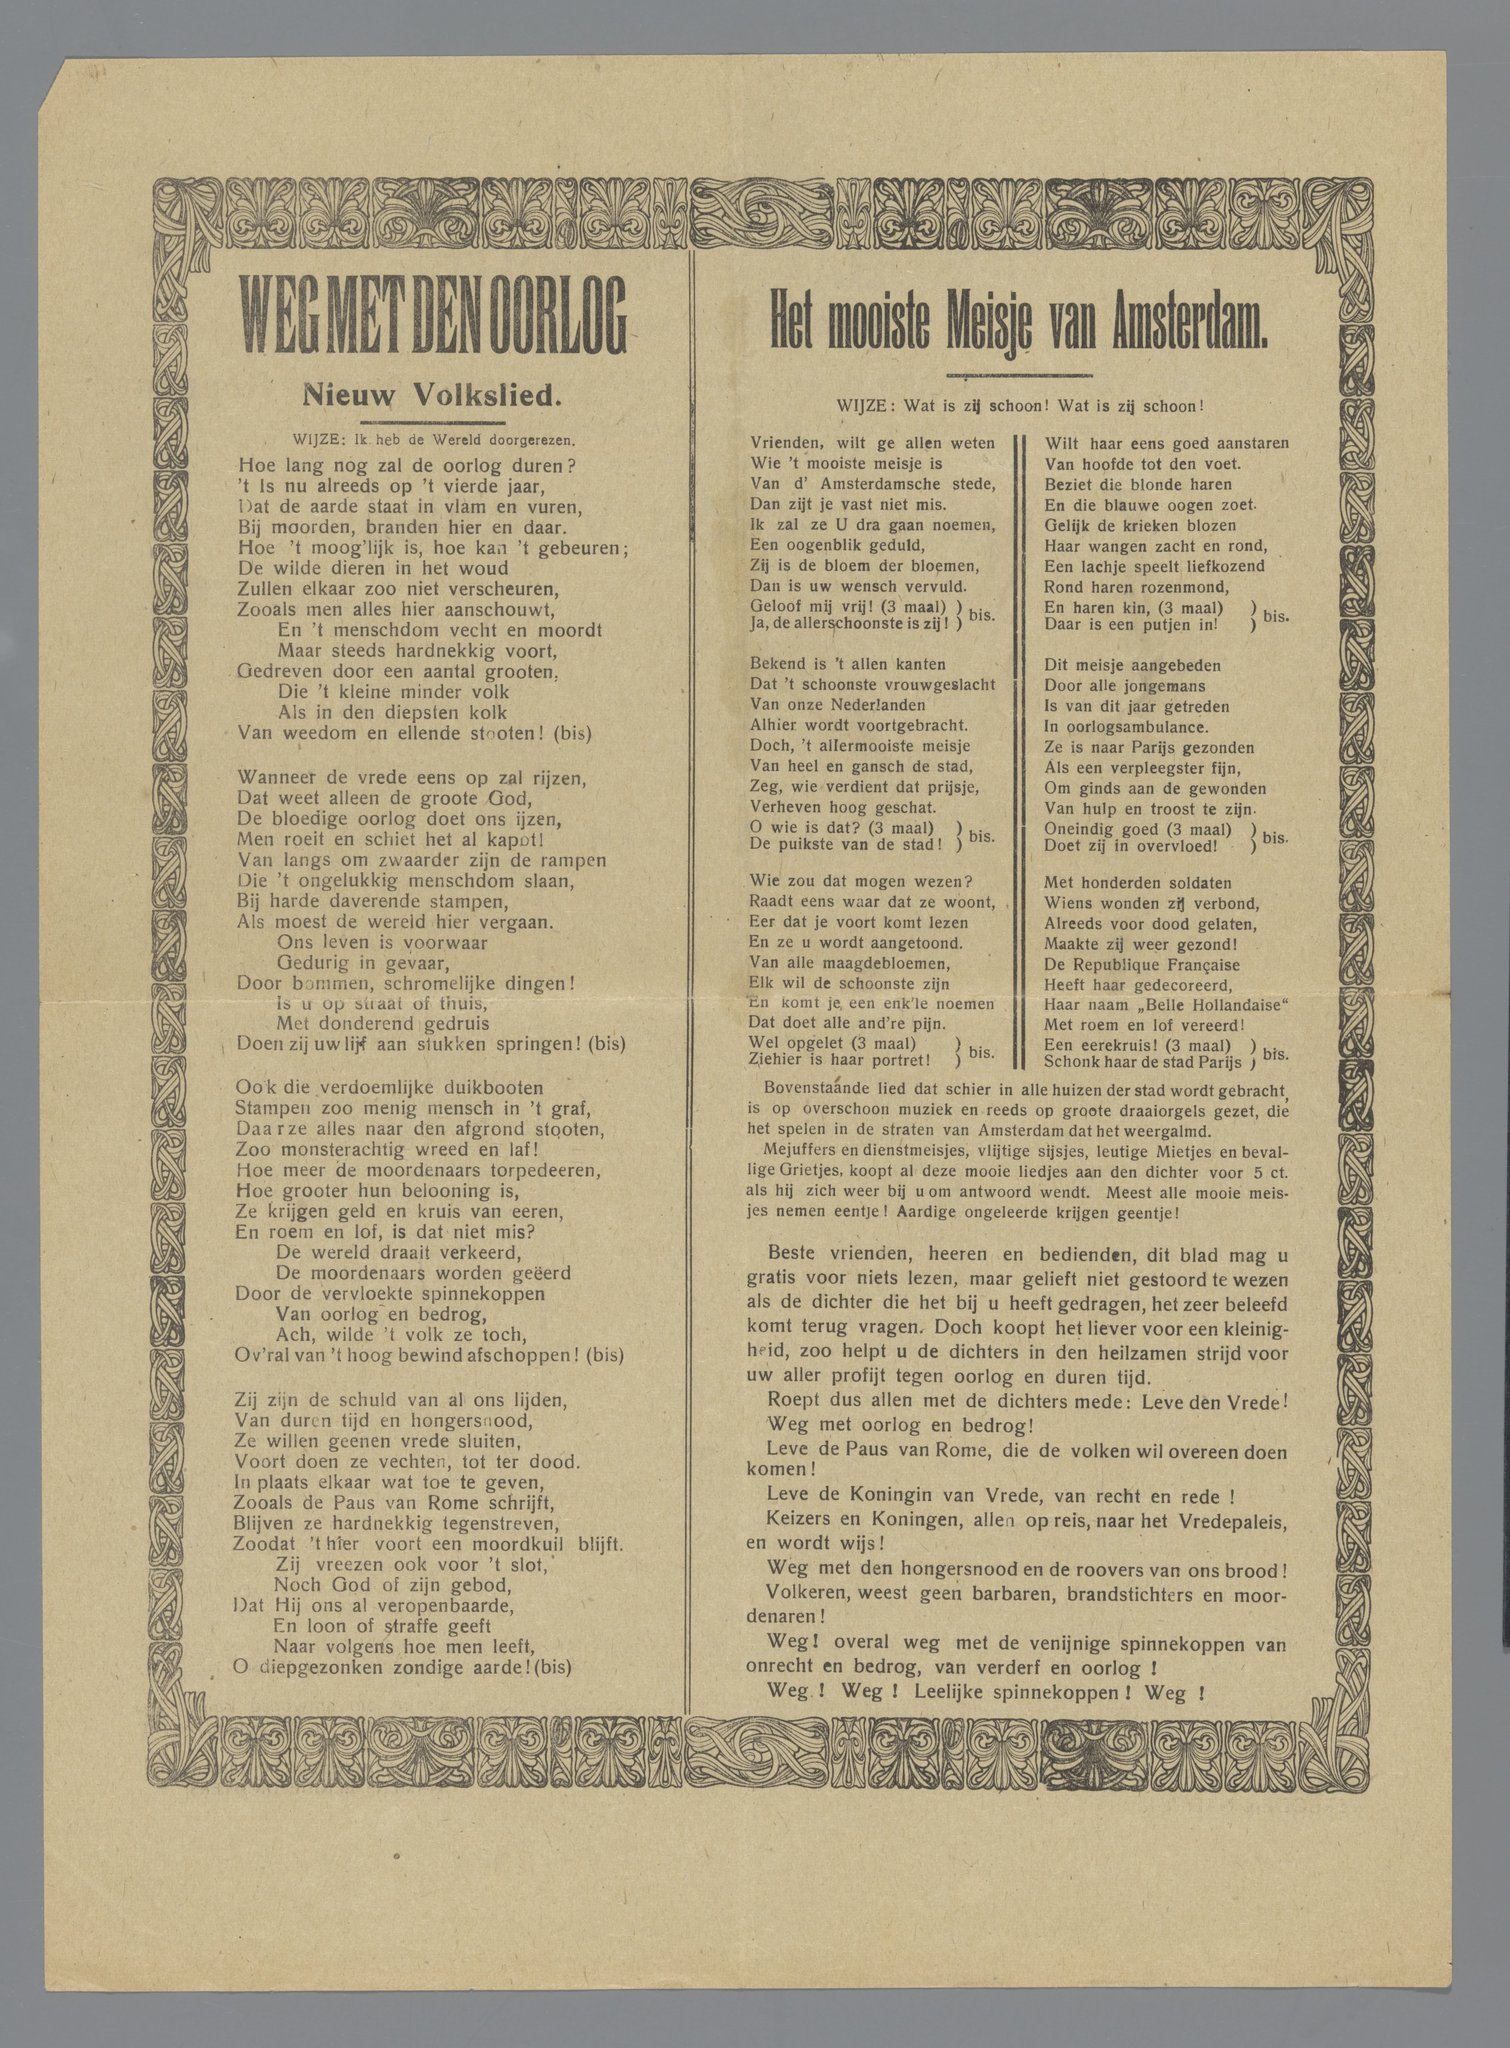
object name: pamphlet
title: Weg met den Oorlog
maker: Anonymous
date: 1918-1919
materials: paper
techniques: printing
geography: amsterdam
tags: eerste wereldoorlog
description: Pamflet, tweezijdig bedrukt, m.b.t. het einde van de Eerste Wereldoorlog.